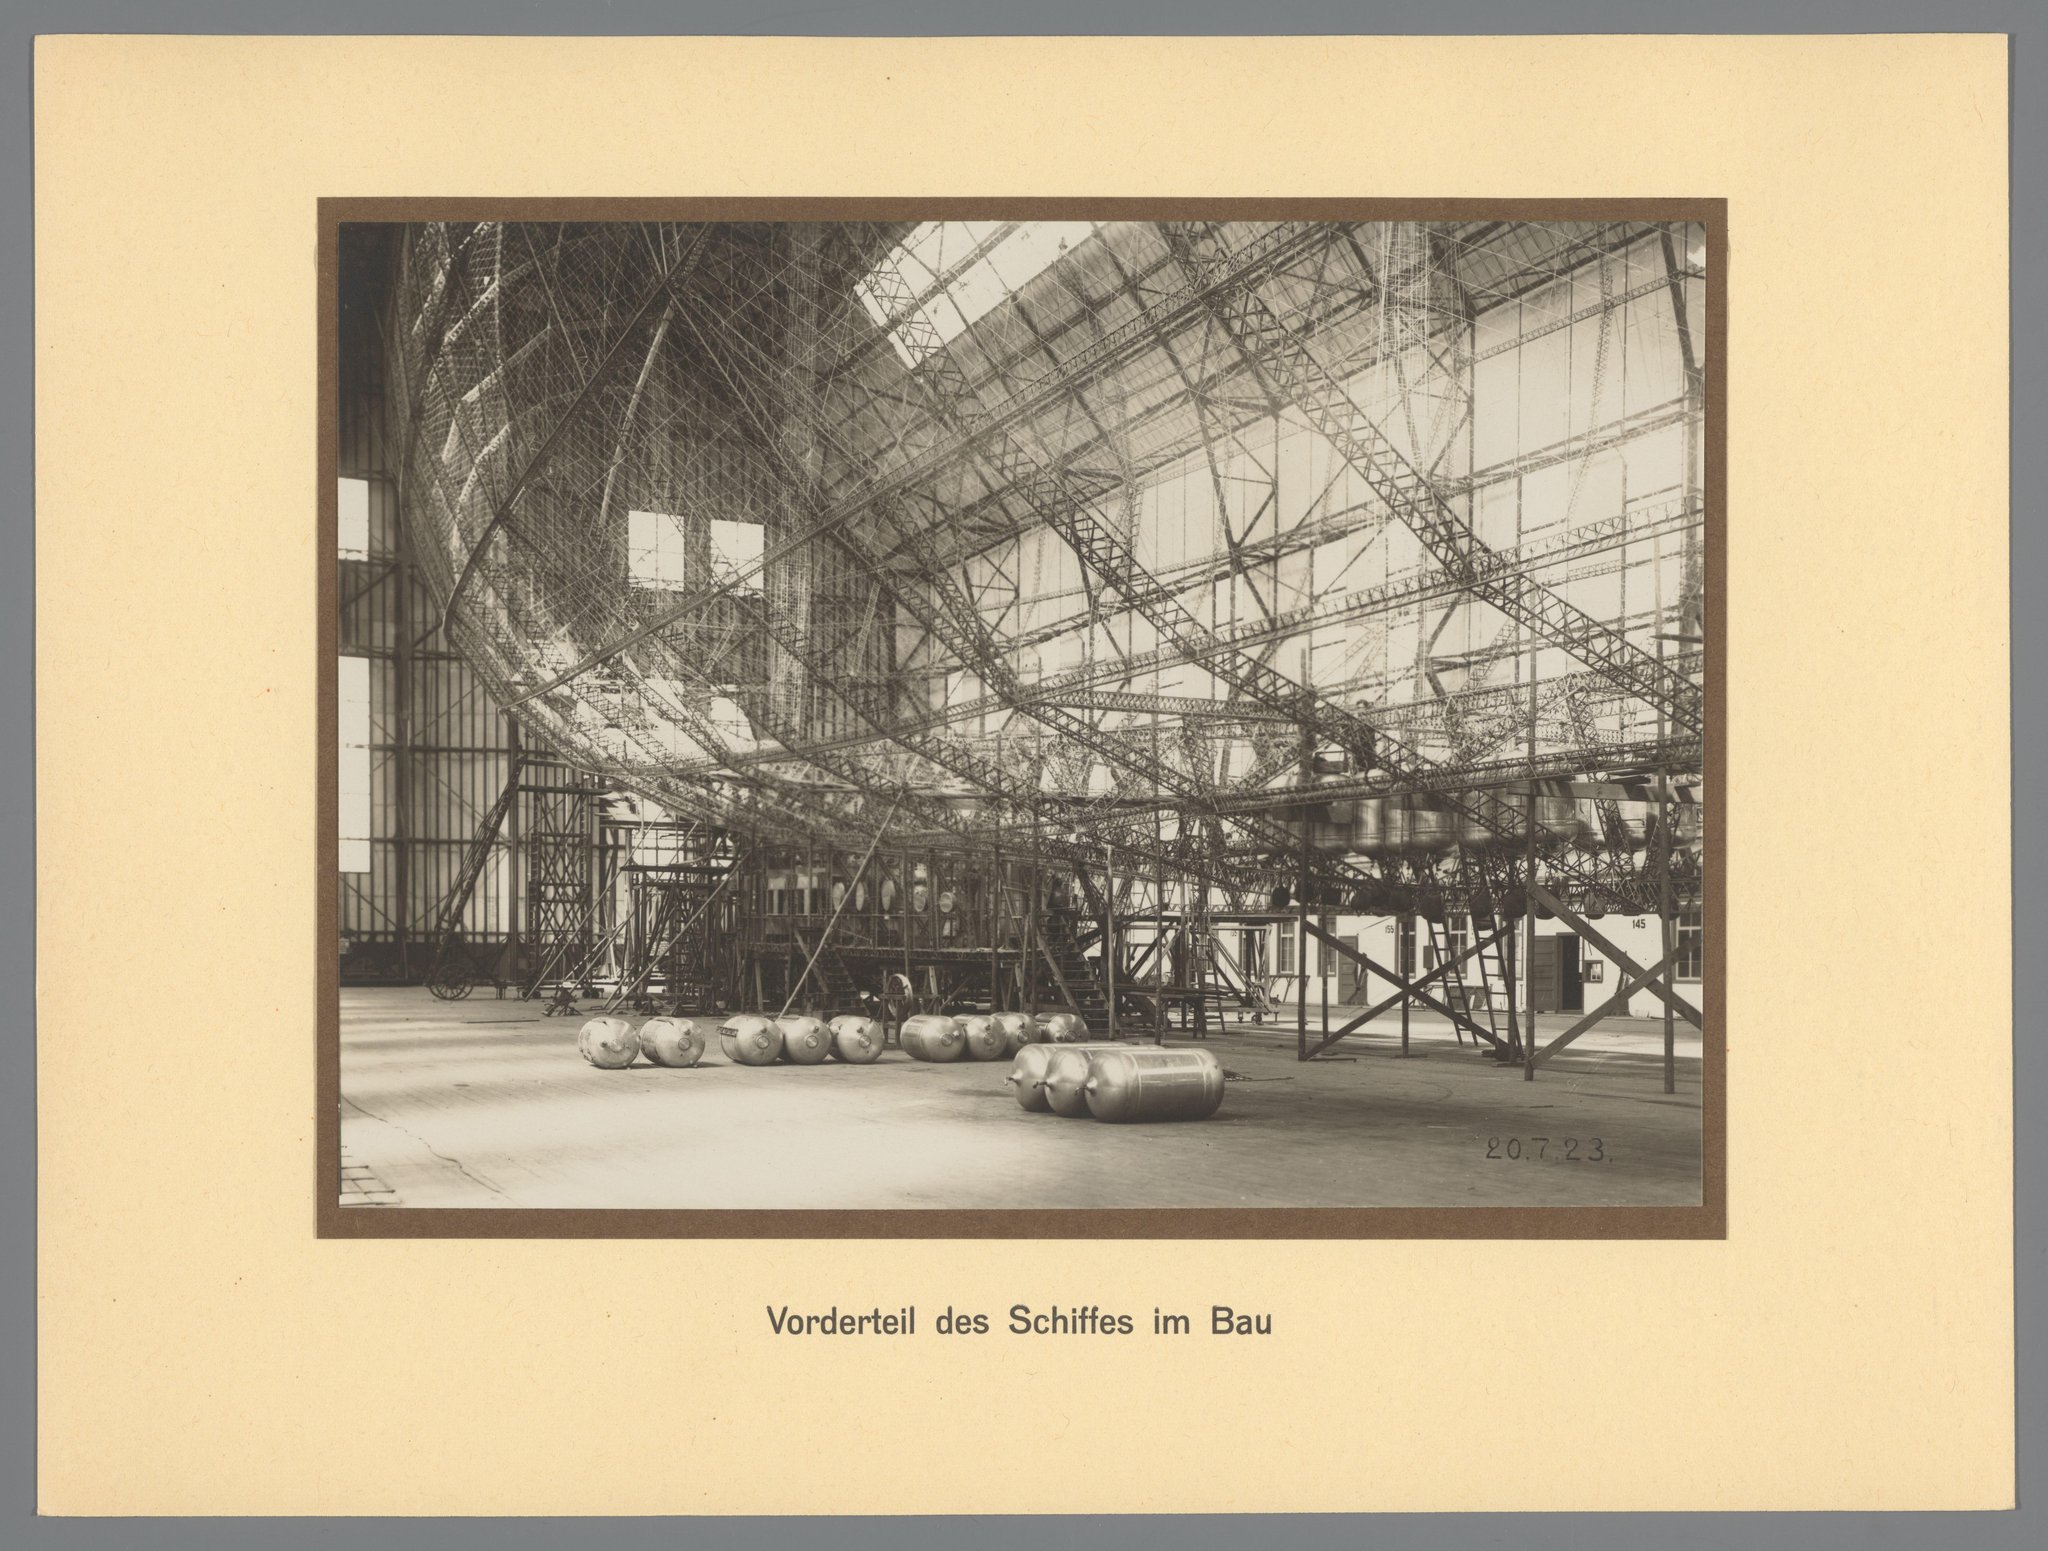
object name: photograph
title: Vorderteil des Schiffes im Bau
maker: Anonymous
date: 1924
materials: cardboard, photographic support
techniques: gelatin silver print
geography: germany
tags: 46c35 airship, zeppelin, hangar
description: Bouw van de zeppelin. Onderdeel van een map twintig productfoto's van het Zeppelinluchtschip LZ 126.